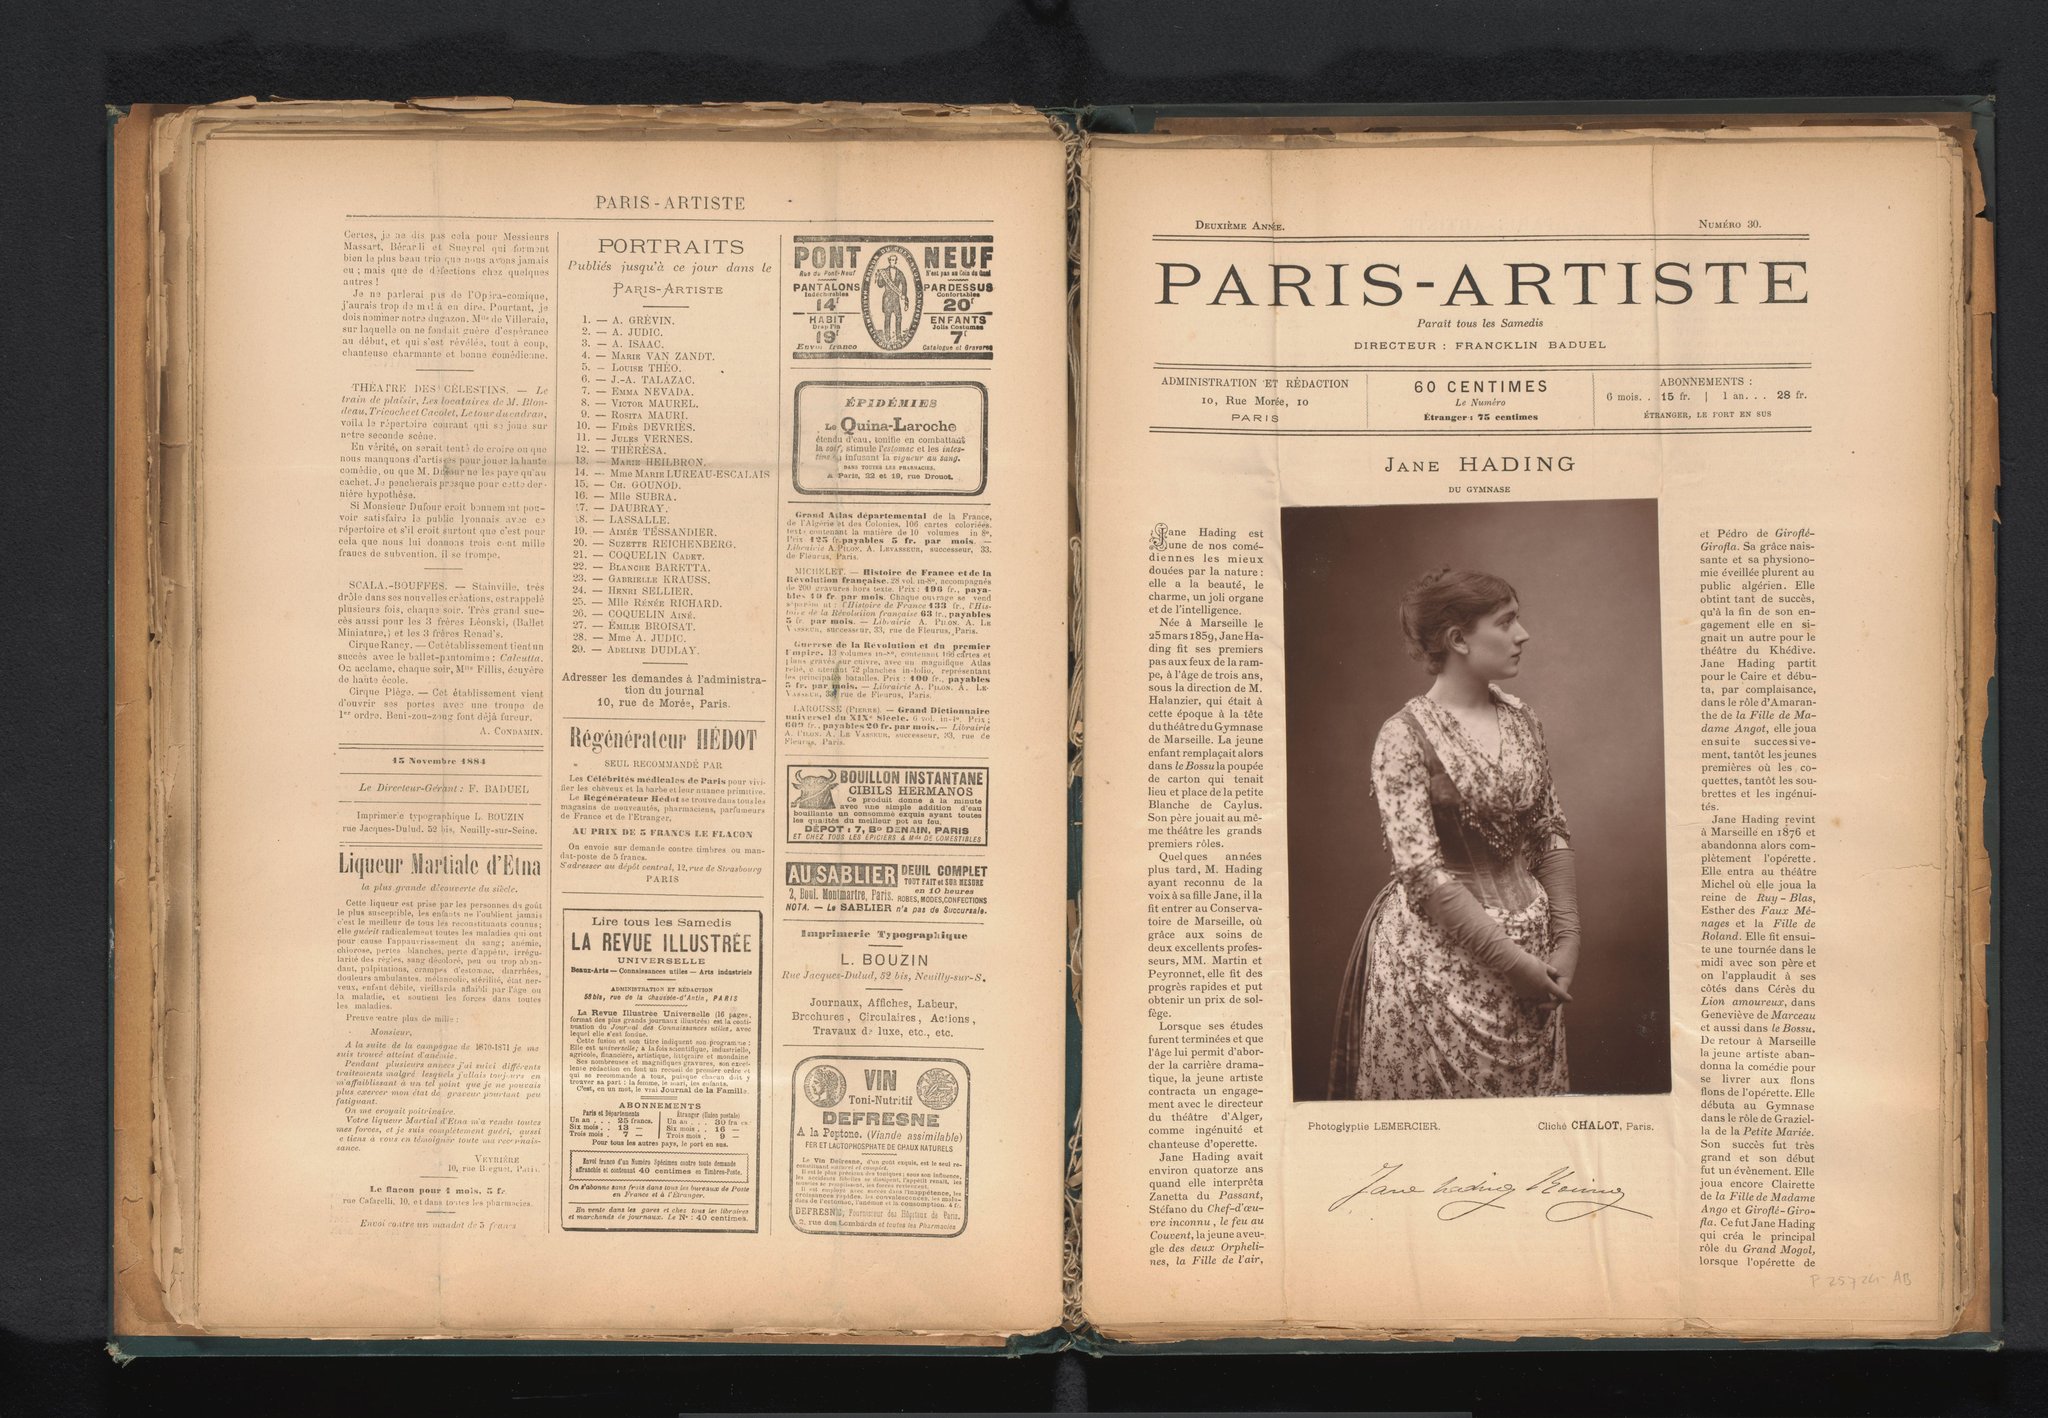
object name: photomechanical print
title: Portret van Jane Hading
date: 1875-1884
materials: paper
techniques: woodburytype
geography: paris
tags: historical persons - bb - woman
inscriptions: inscription: ‘Du gymnase’